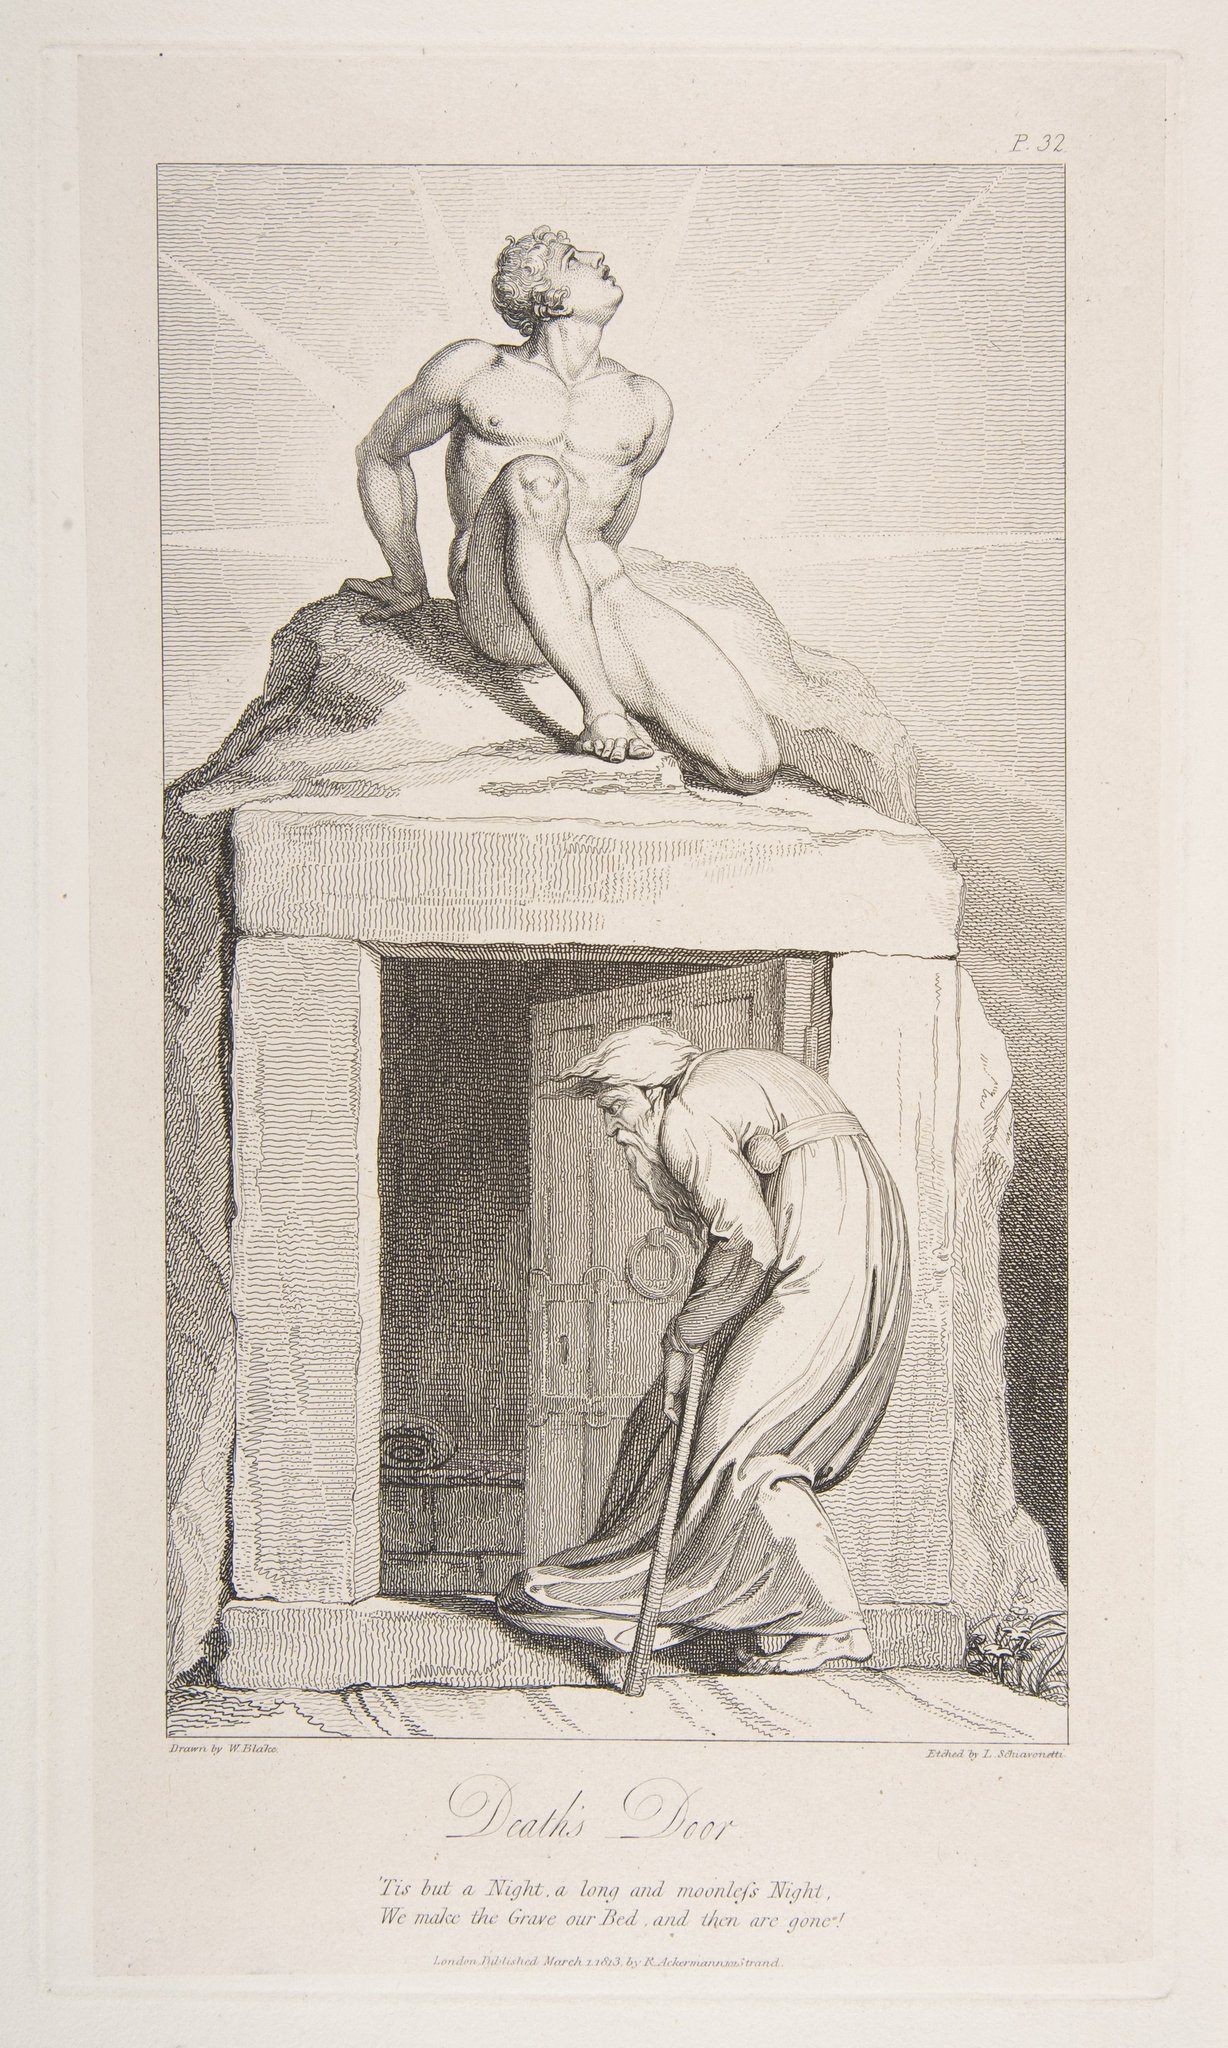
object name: print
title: Death's Door, from "The Grave," a Poem by Robert Blair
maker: william blake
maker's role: artist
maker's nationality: british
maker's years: 1757-1827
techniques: engraving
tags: doors,men,male nudes